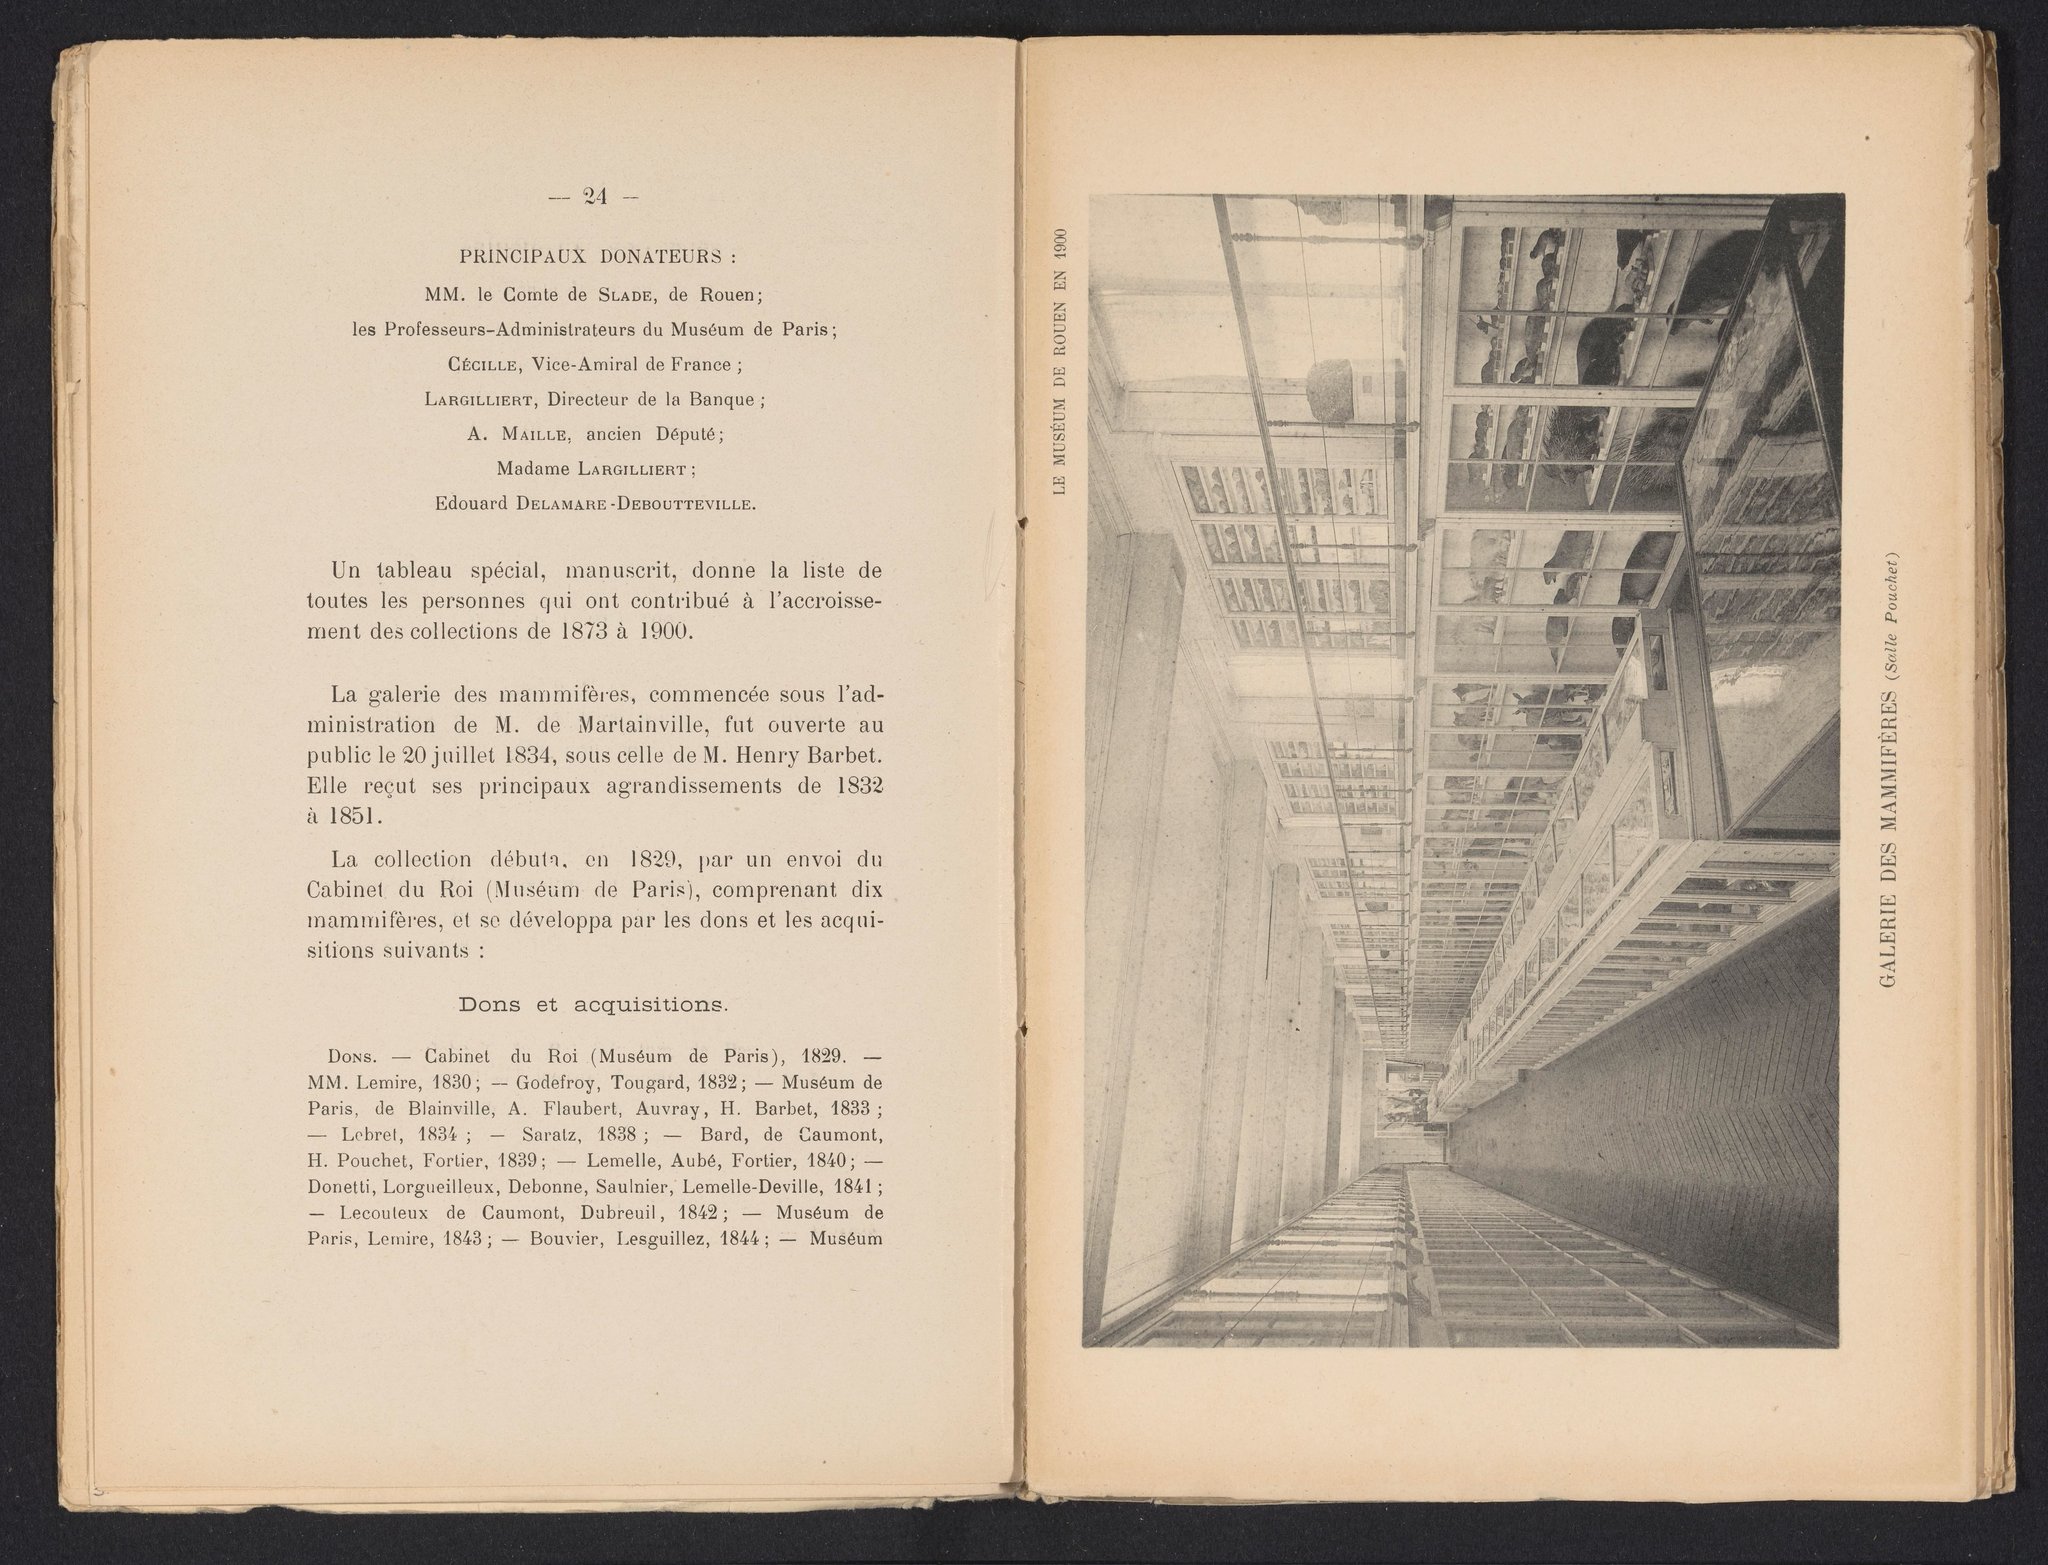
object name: page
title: Galerie des Mammifères (salle Pouchet)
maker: Anonymous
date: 1890-1900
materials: paper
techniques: photograph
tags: mammals, permanent exhibition, museum